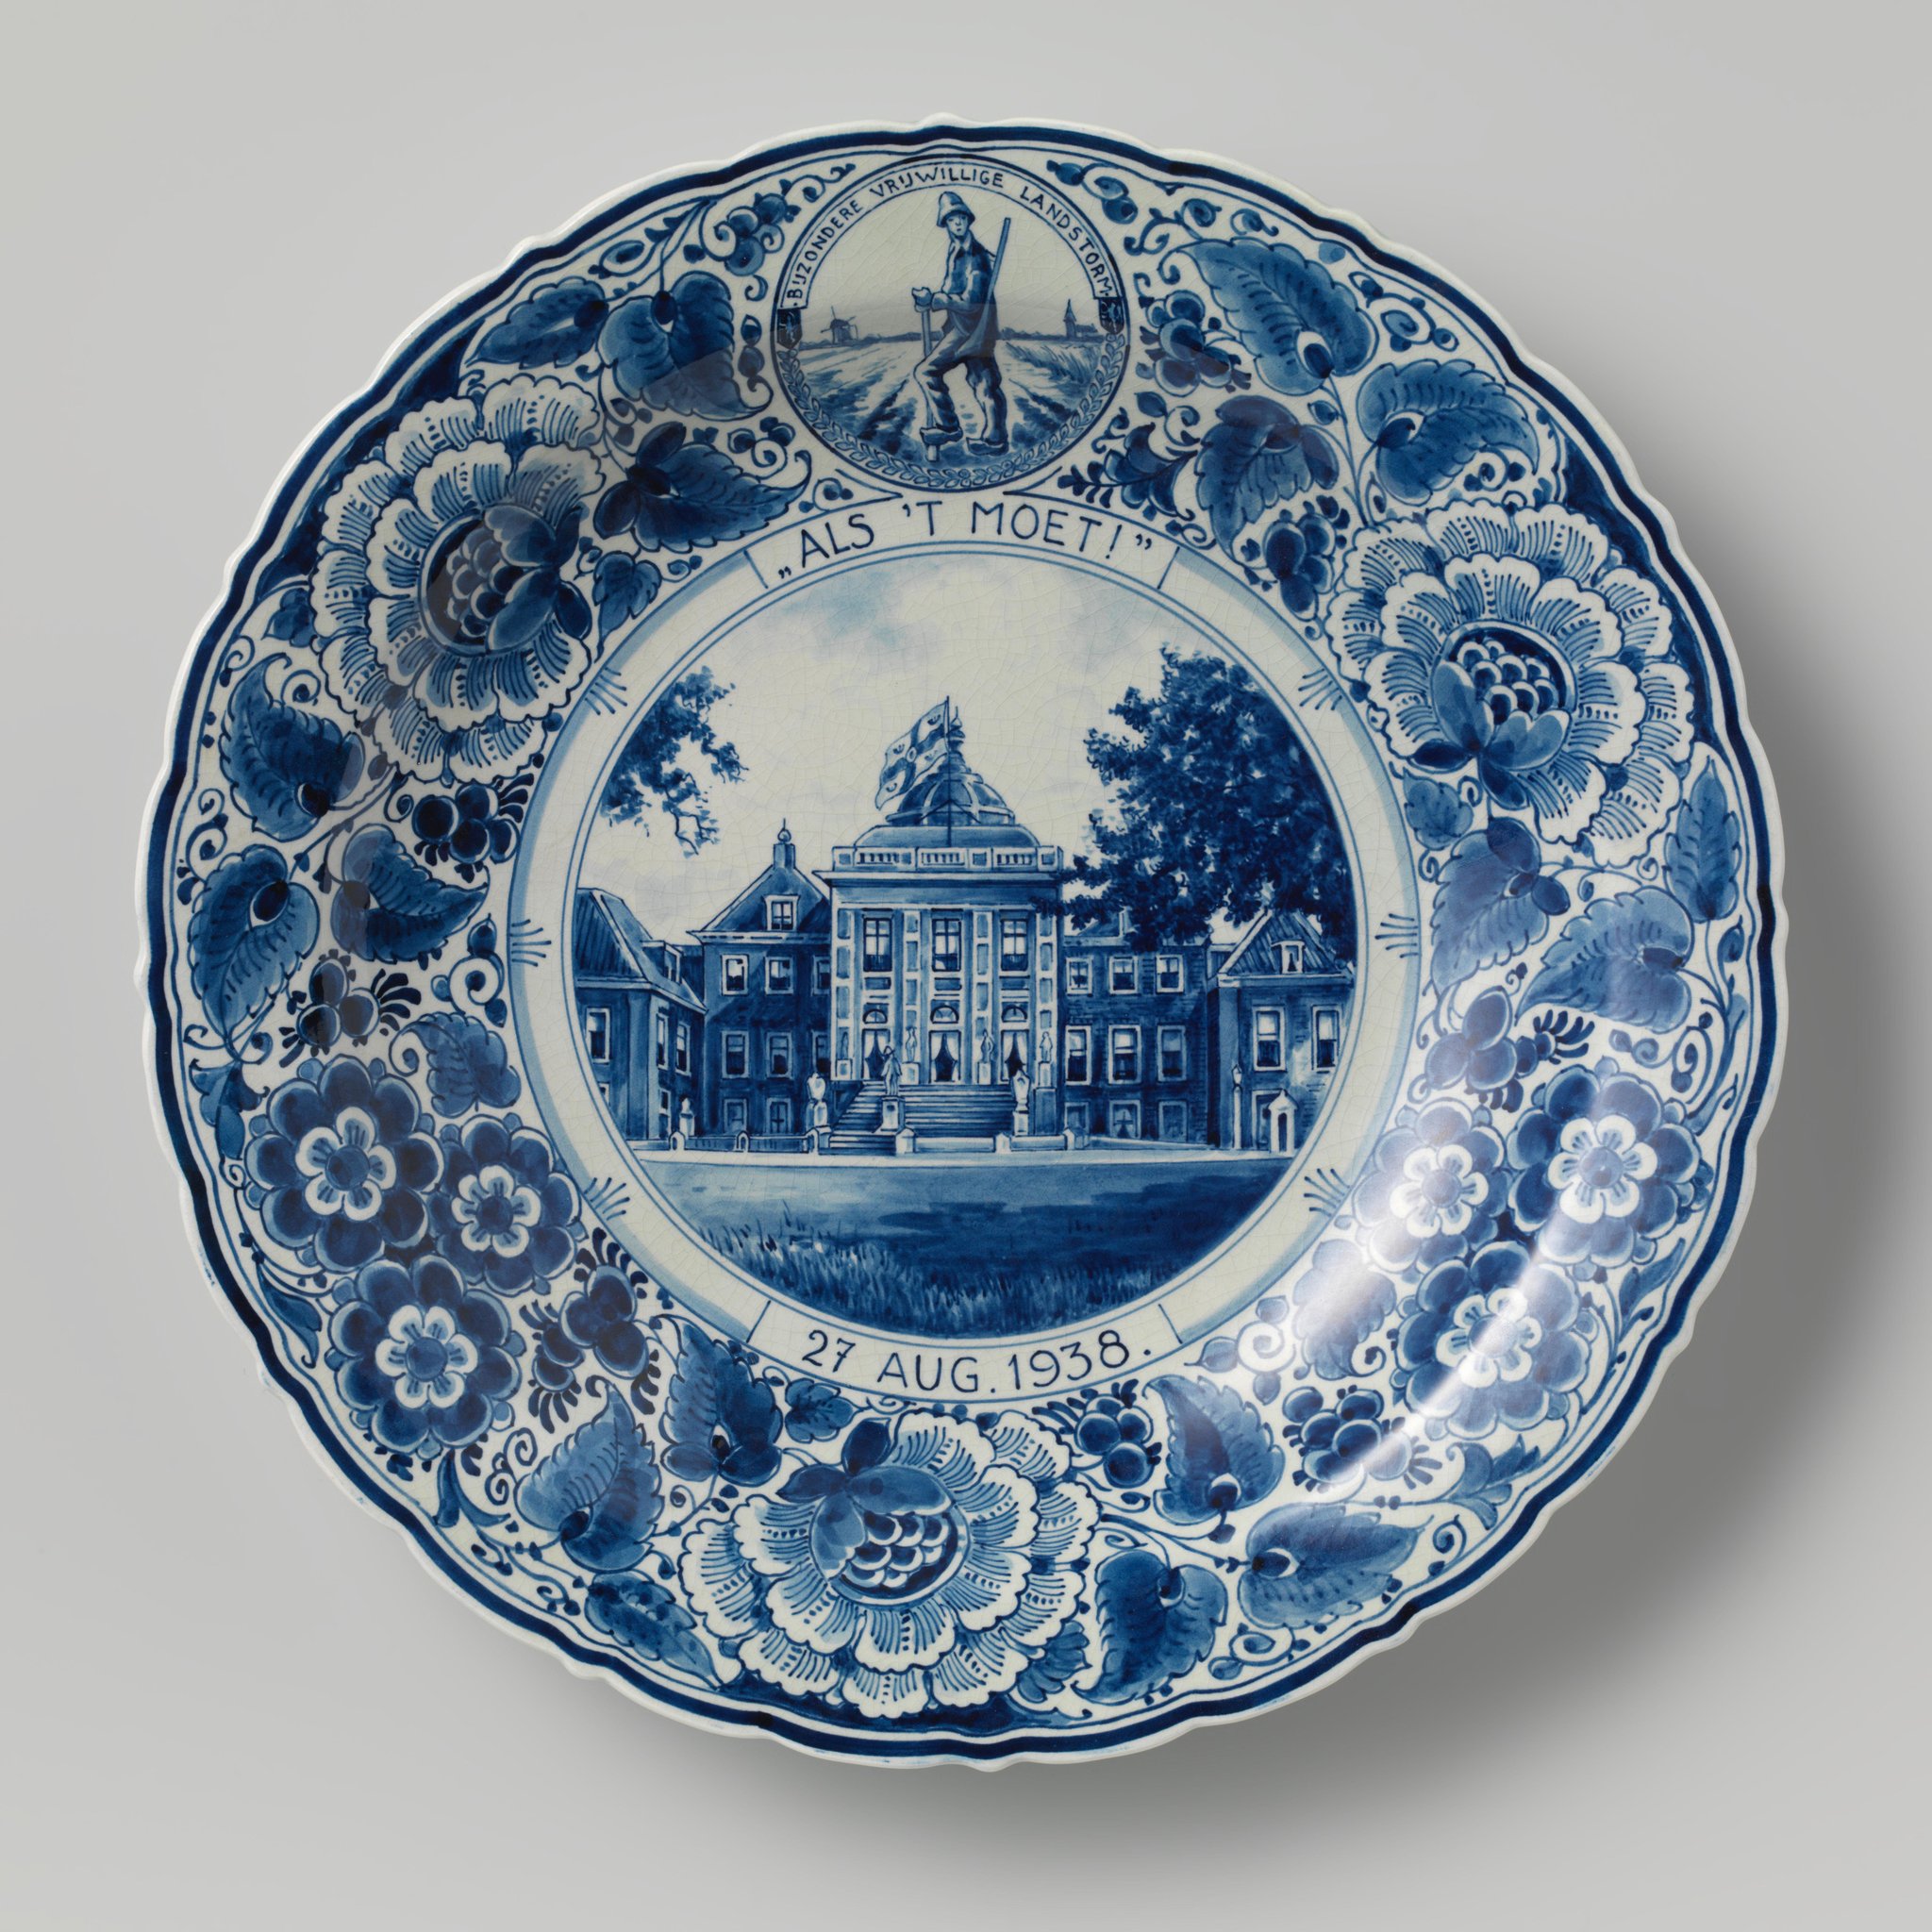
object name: plate dish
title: 20-jarig Bestaan van de Bijzondere Vrijwillige Landstorm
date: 1938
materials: earthenware, fiber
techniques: printing, firing, painted, vitrification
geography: delft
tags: netherlands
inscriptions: inscription: ‘BIJZONDERE VRIJWILLIGE LANDSTORM / ALS 'T MOET’, inscription: ‘1898 - 1938 / Regeeringsjubileum van / Hare Mejestein Koningin Wilhelmina / 27 Augustus 1936...’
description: Delfts blauw bord met geprofileerde rand. Voorzijde midden boven op de rand medaillon waarin de voorstelling van een staande man naar links met geweer over de schouder, twee handen en één voet op spade, in een akker. Op het plat van het bord Paleis Huis ten Bosch. Op de rand opschrift en verder bloemmotieven. Keerzijde opschrift. Ter gelegenheid van het 20-jarig bestaan van de Bijzondere Vrijwillige Landstorm op 27 augustus 1938.